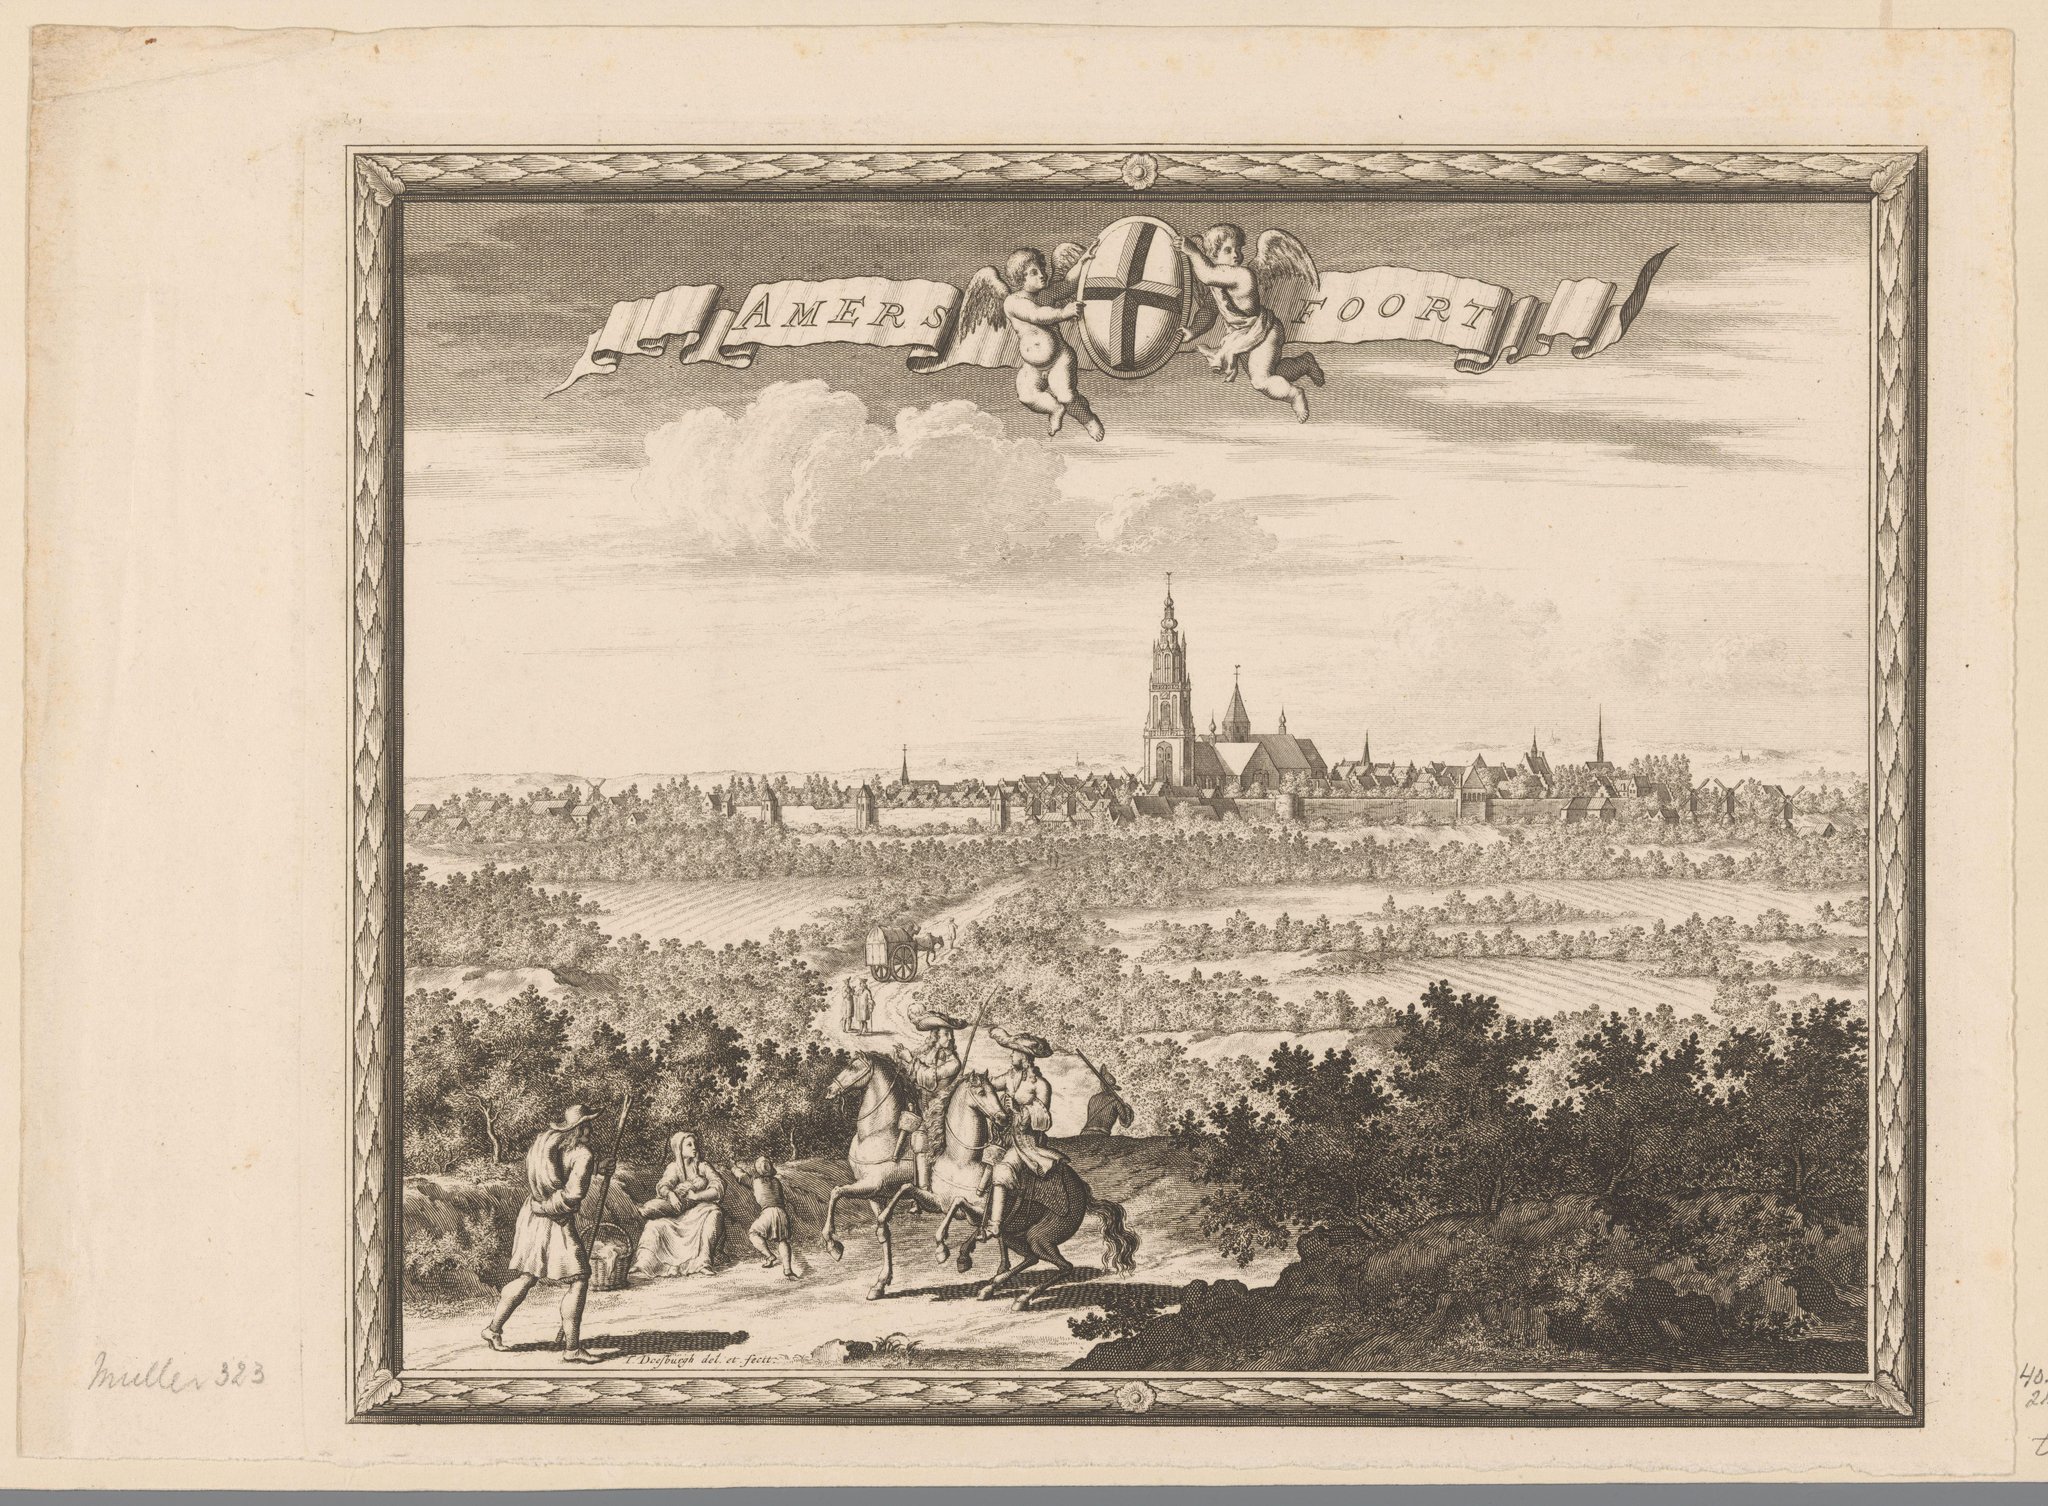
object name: print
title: Gezicht op Amersfoort vanaf de berg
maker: thomas doesburgh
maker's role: print maker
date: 1683-1714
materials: paper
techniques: engraving, etching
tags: city-view in general; 'veduta', church (exterior)